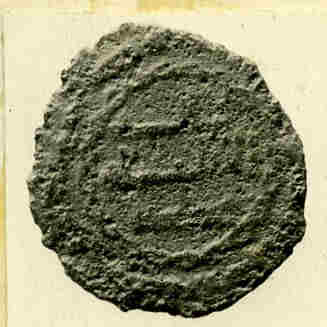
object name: coin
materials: copper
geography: iran